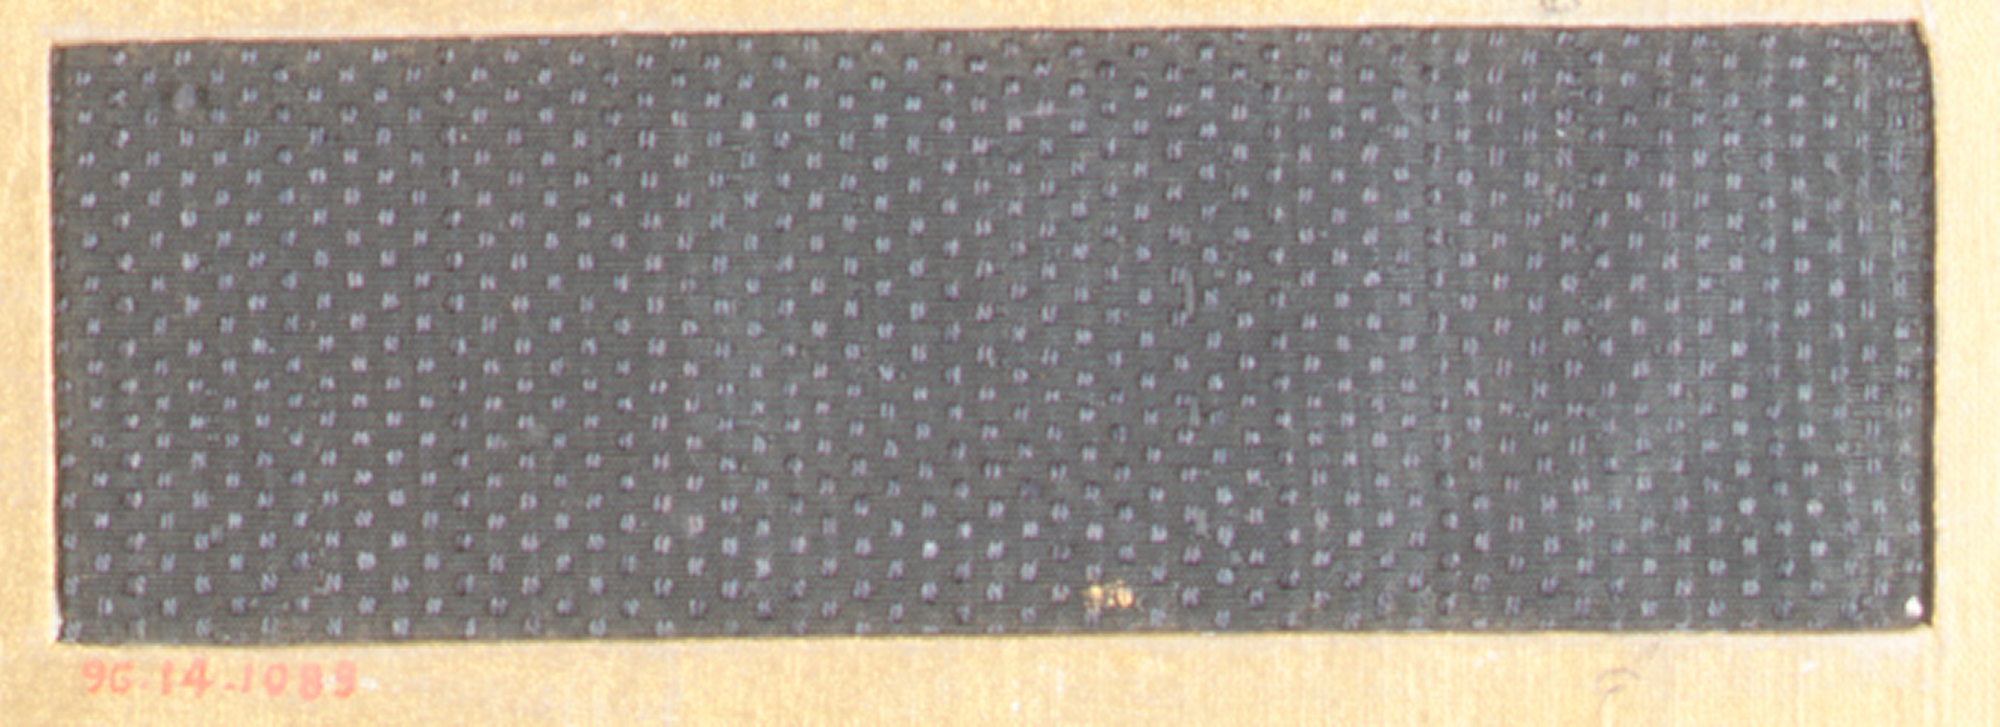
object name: piece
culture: japanese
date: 1701-1900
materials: silk